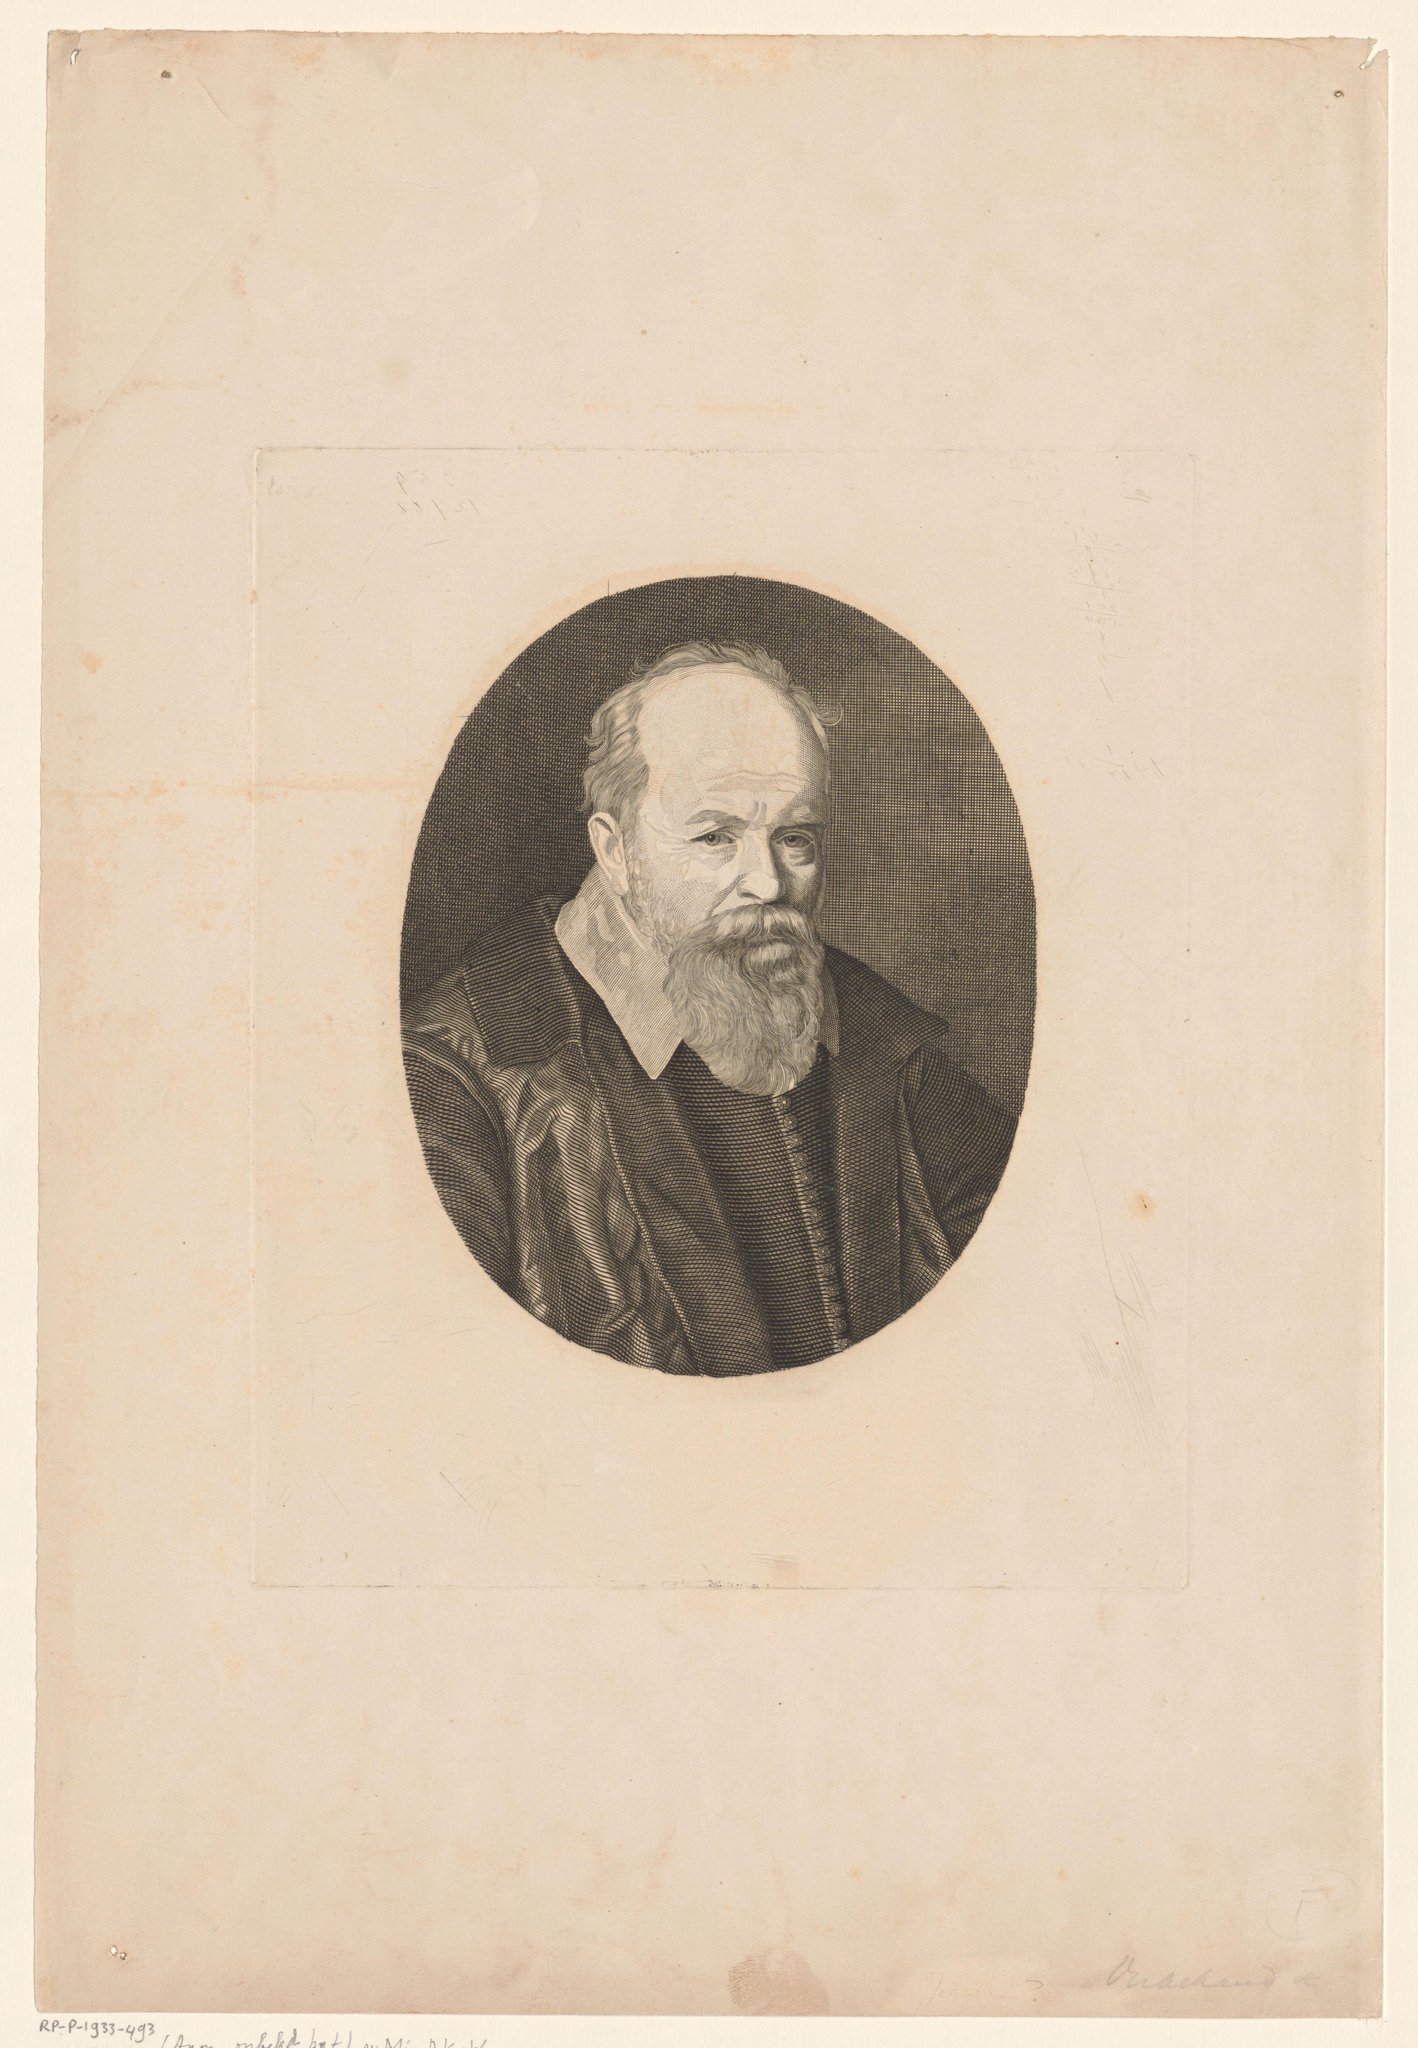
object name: print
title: Portret van Pierre Jeannin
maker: Anonymous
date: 1650-1749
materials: paper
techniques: engraving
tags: paris, historical persons, politician, e.g. party leader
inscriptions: collector's mark: Lugt 2228